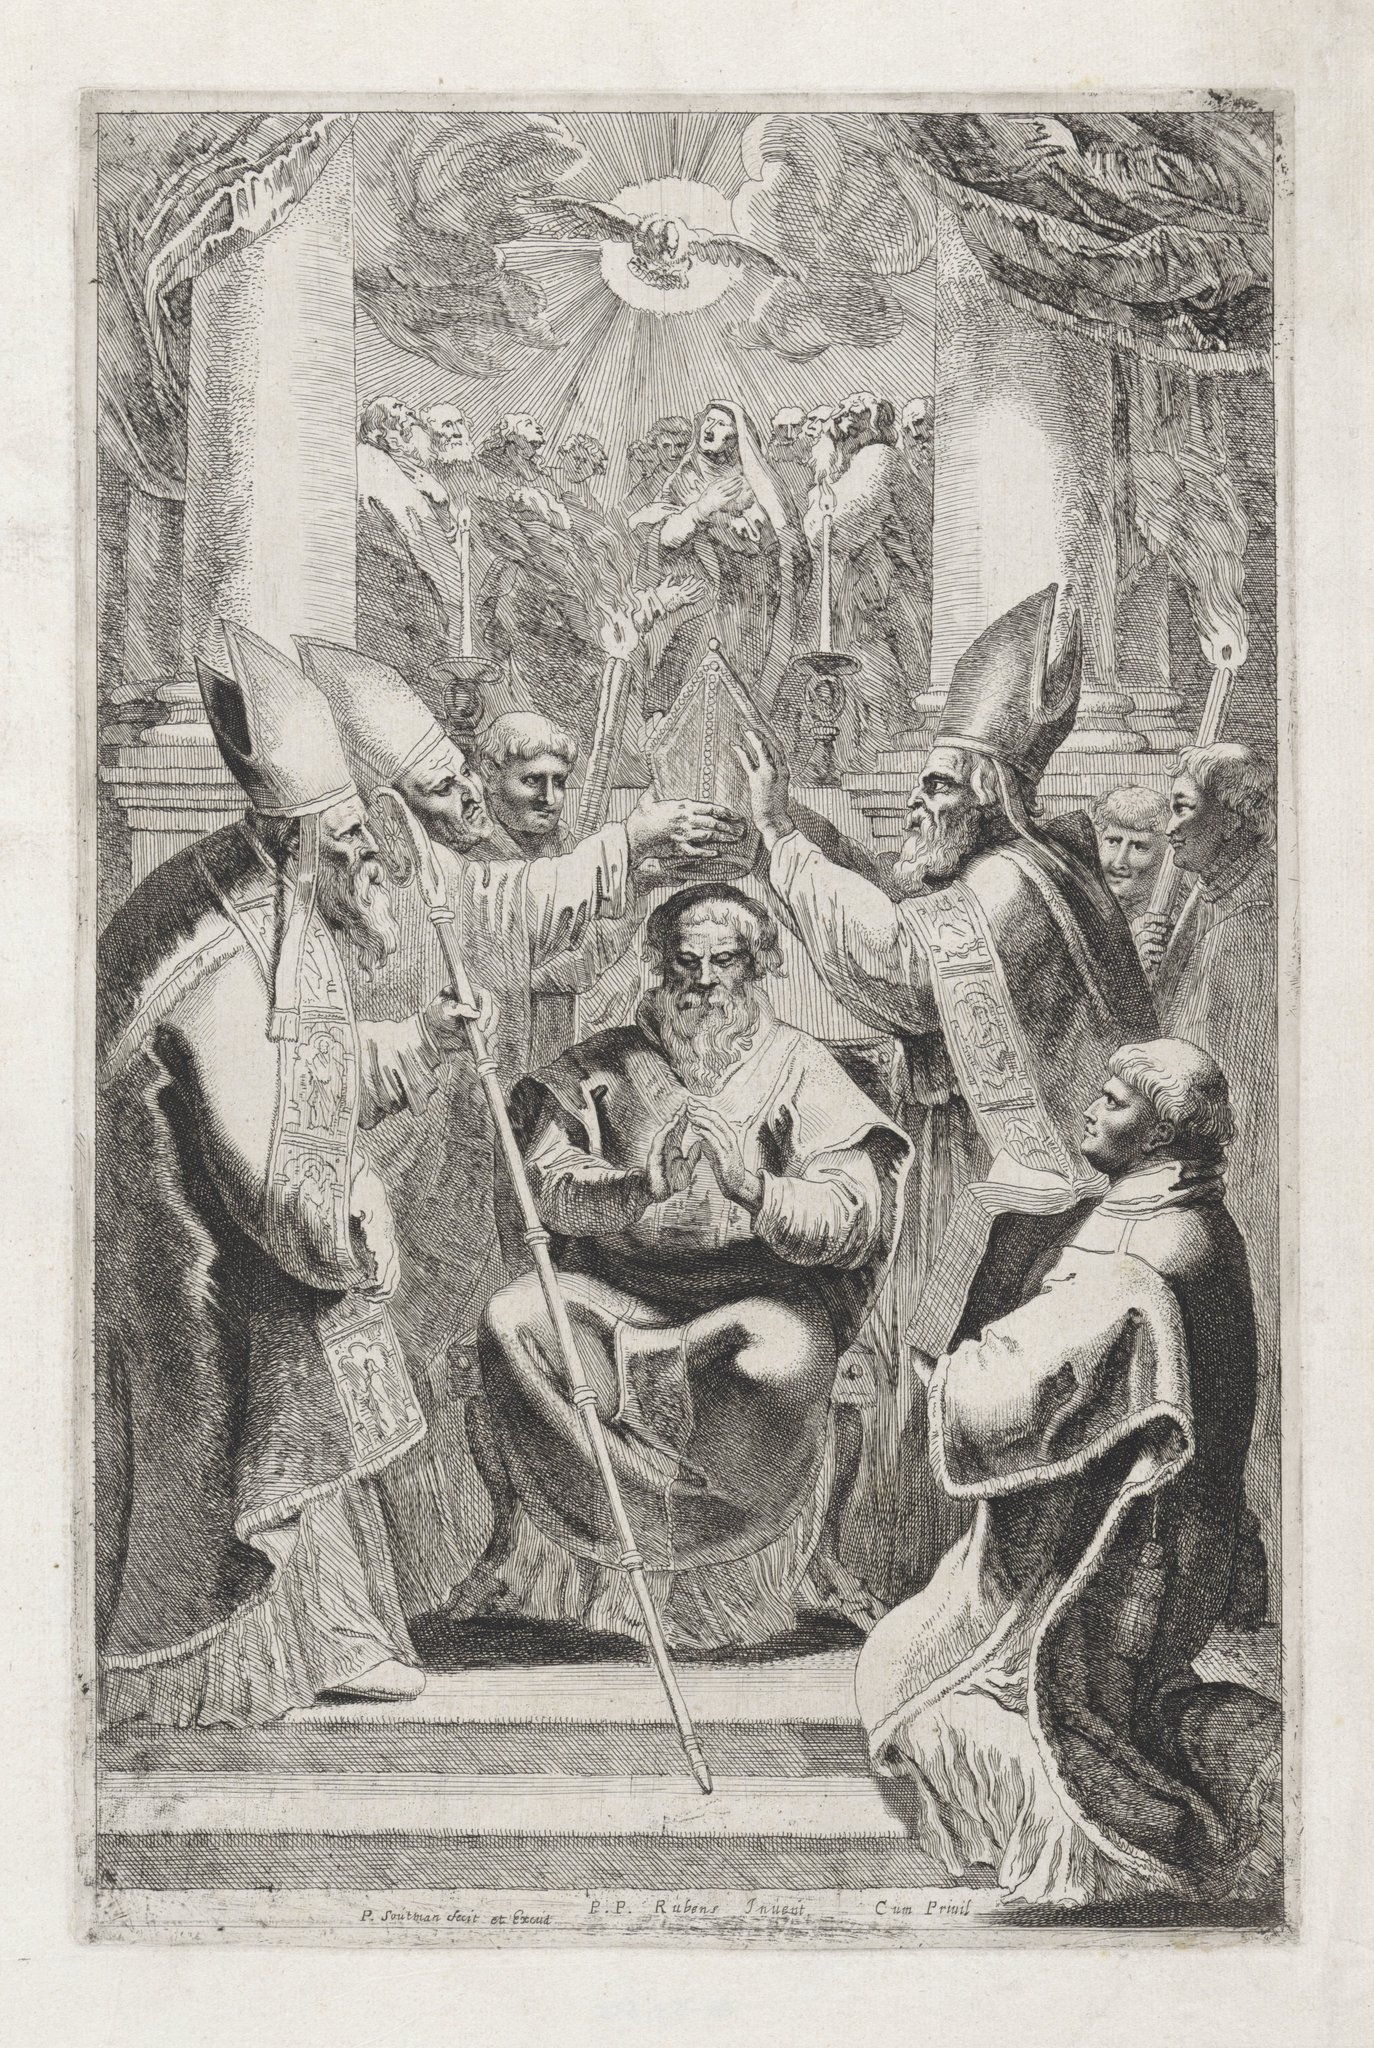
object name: print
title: Inwijding van een bisschop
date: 1616-1657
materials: paper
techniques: engraving, etching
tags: archbishop, bishop, etc. (roman catholic), ritual consecration ~ christian religion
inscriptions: collector's mark: Lugt 240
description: Twee bisschoppen houden een mijter boven het hoofd van een nieuw te wijden bisschop, die op een stoel zit met gevouwen handen. Anderen kijken toe. Op de achtergrond Maria en de apostelen die omhoog kijken naar de H. Geest als duif.